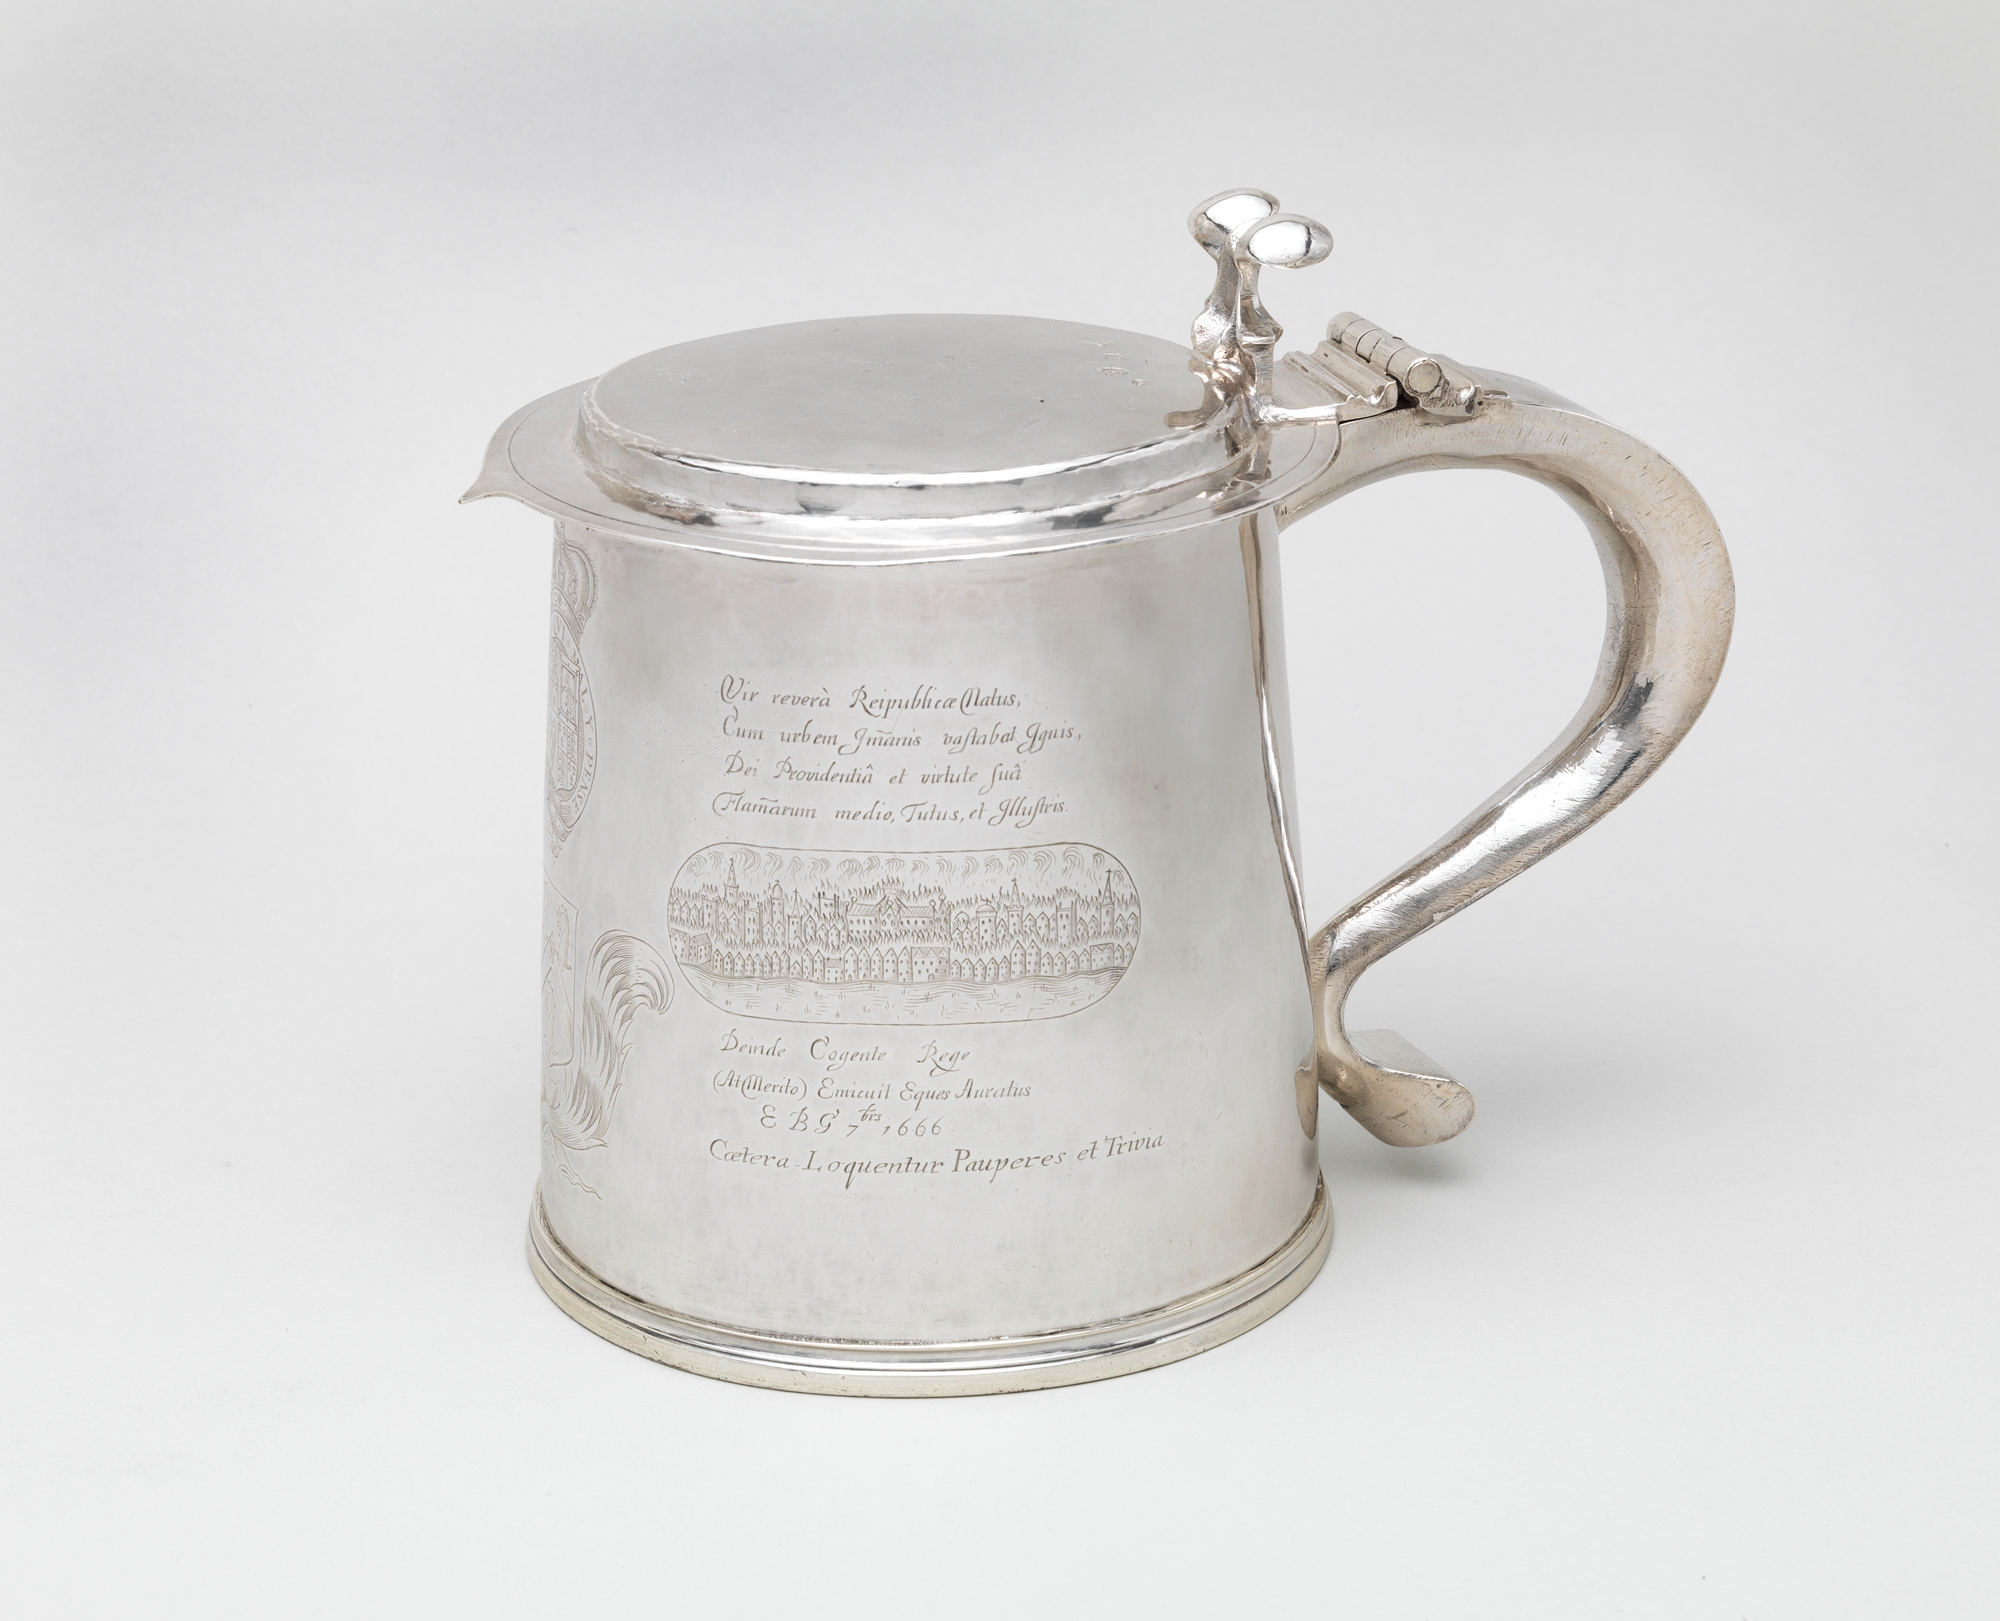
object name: tankard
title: Tankard engraved with scenes of the Great Plague and the Great Fire of London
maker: i n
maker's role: maker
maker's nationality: british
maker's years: 1650-1699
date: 1675-1676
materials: silver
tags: cities,fire,burials,coat of arms